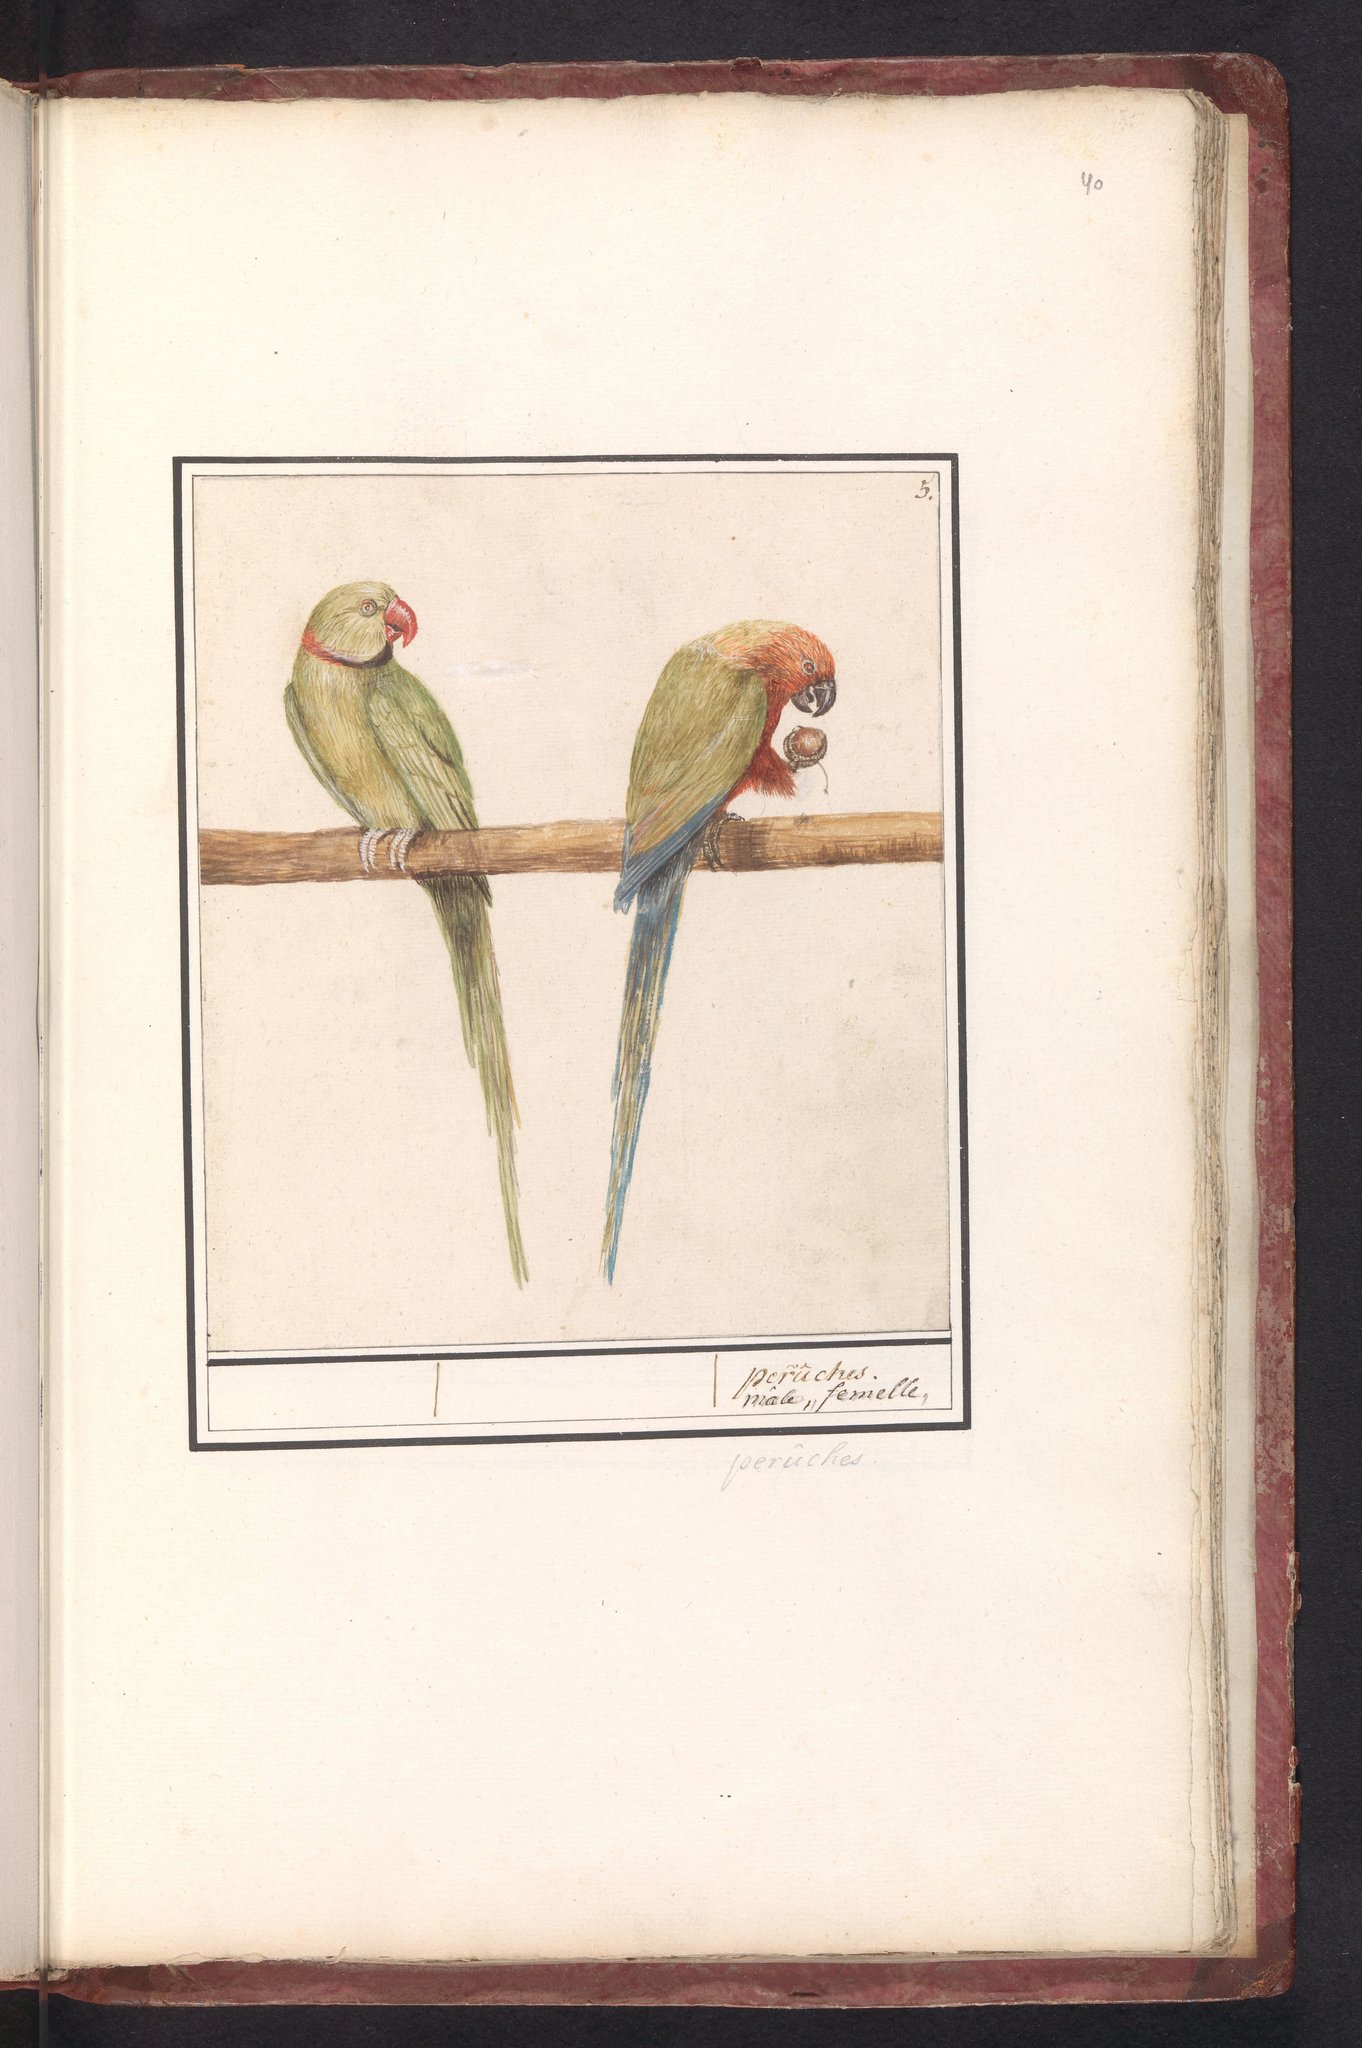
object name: drawing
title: Alexandrine Parakeet and Red-breasted Parakeet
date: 1596-1610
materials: paint, paper, watercolor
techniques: brush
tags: ornamental birds: alexandrine parakeet, ornamental birds: red-breasted parakeet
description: Grote Alexanderparkiet en Kleine Alexanderparkiet. Genummerd linksboven: 5. Rechtsboven de naam. Onderdeel van het tweede album met tekeningen van vogels. Vierde van twaalf albums met tekeningen van dieren, vogels en planten bekend rond 1600, gemaakt in opdracht van keizer Rudolf II. Met toelichting in Nederlands, Latijn en Frans.